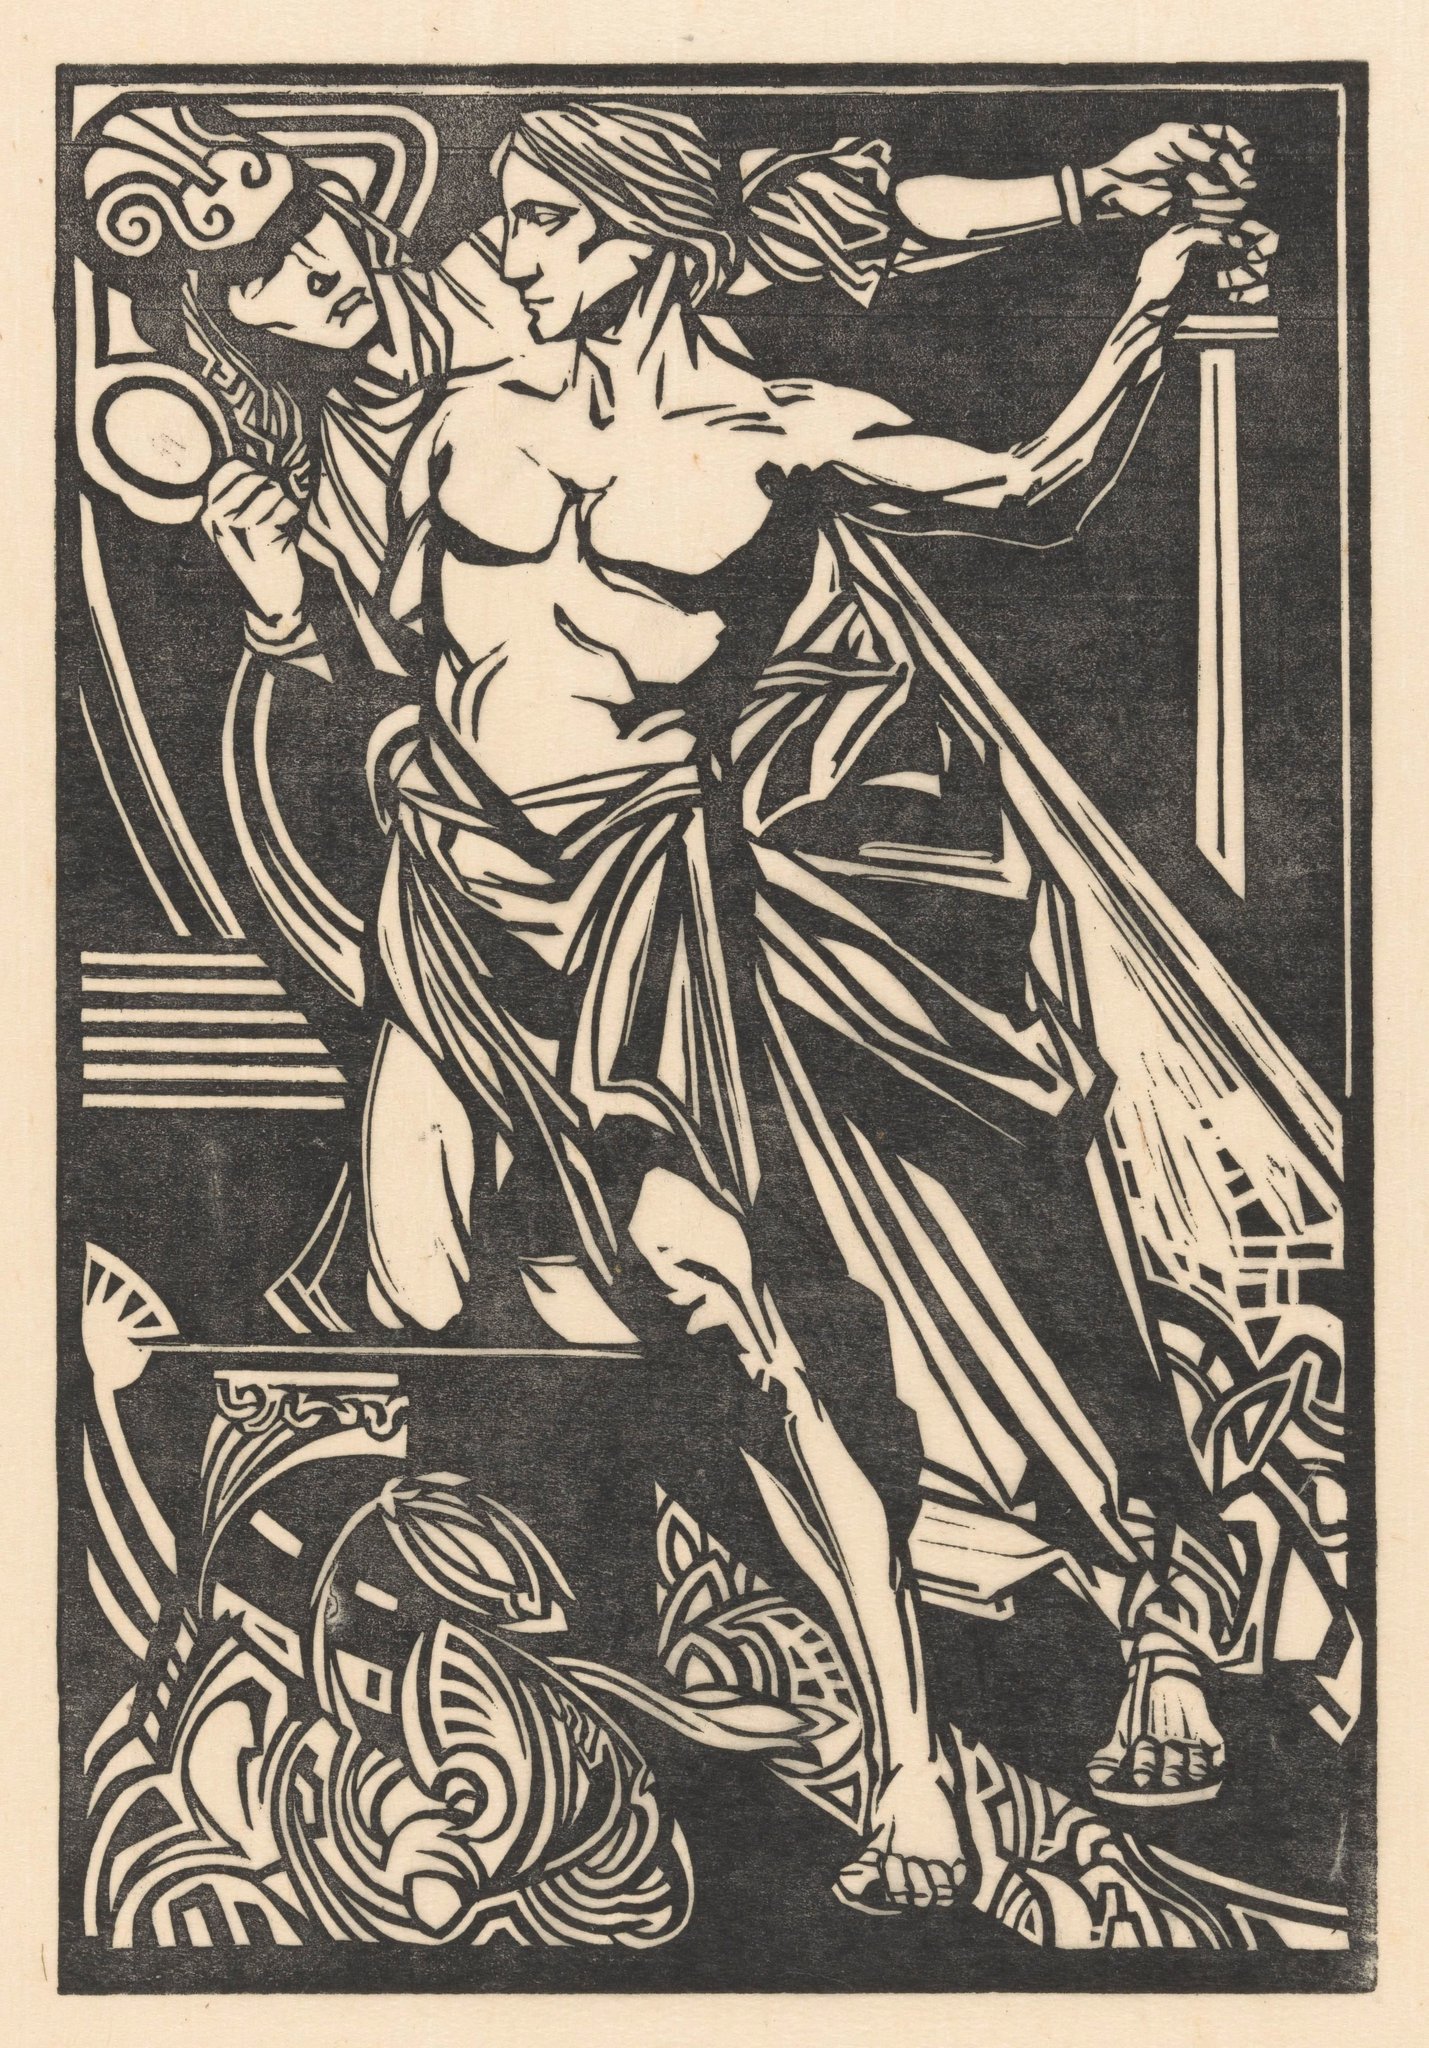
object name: print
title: Perseus en Minerva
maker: johannes josephus aarts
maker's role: draughtsman, print maker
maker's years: 1871-1934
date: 1922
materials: paper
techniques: woodcut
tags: helmet, mirror, minerva gives perseus the shield (or mirror), hacking and thrusting weapons: sword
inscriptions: collector's mark: Lugt 2166, collector's mark: Lugt 2760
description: De staande, halfnaakte Perseus, houdt een zwaard en een spiegel of spiegelend schild in zijn handen. Minerva, achter hem, draagt een helm en houdt het zwaard ook vast. Perseus wordt hier voorbereid op zijn strijd tegen Medusa.